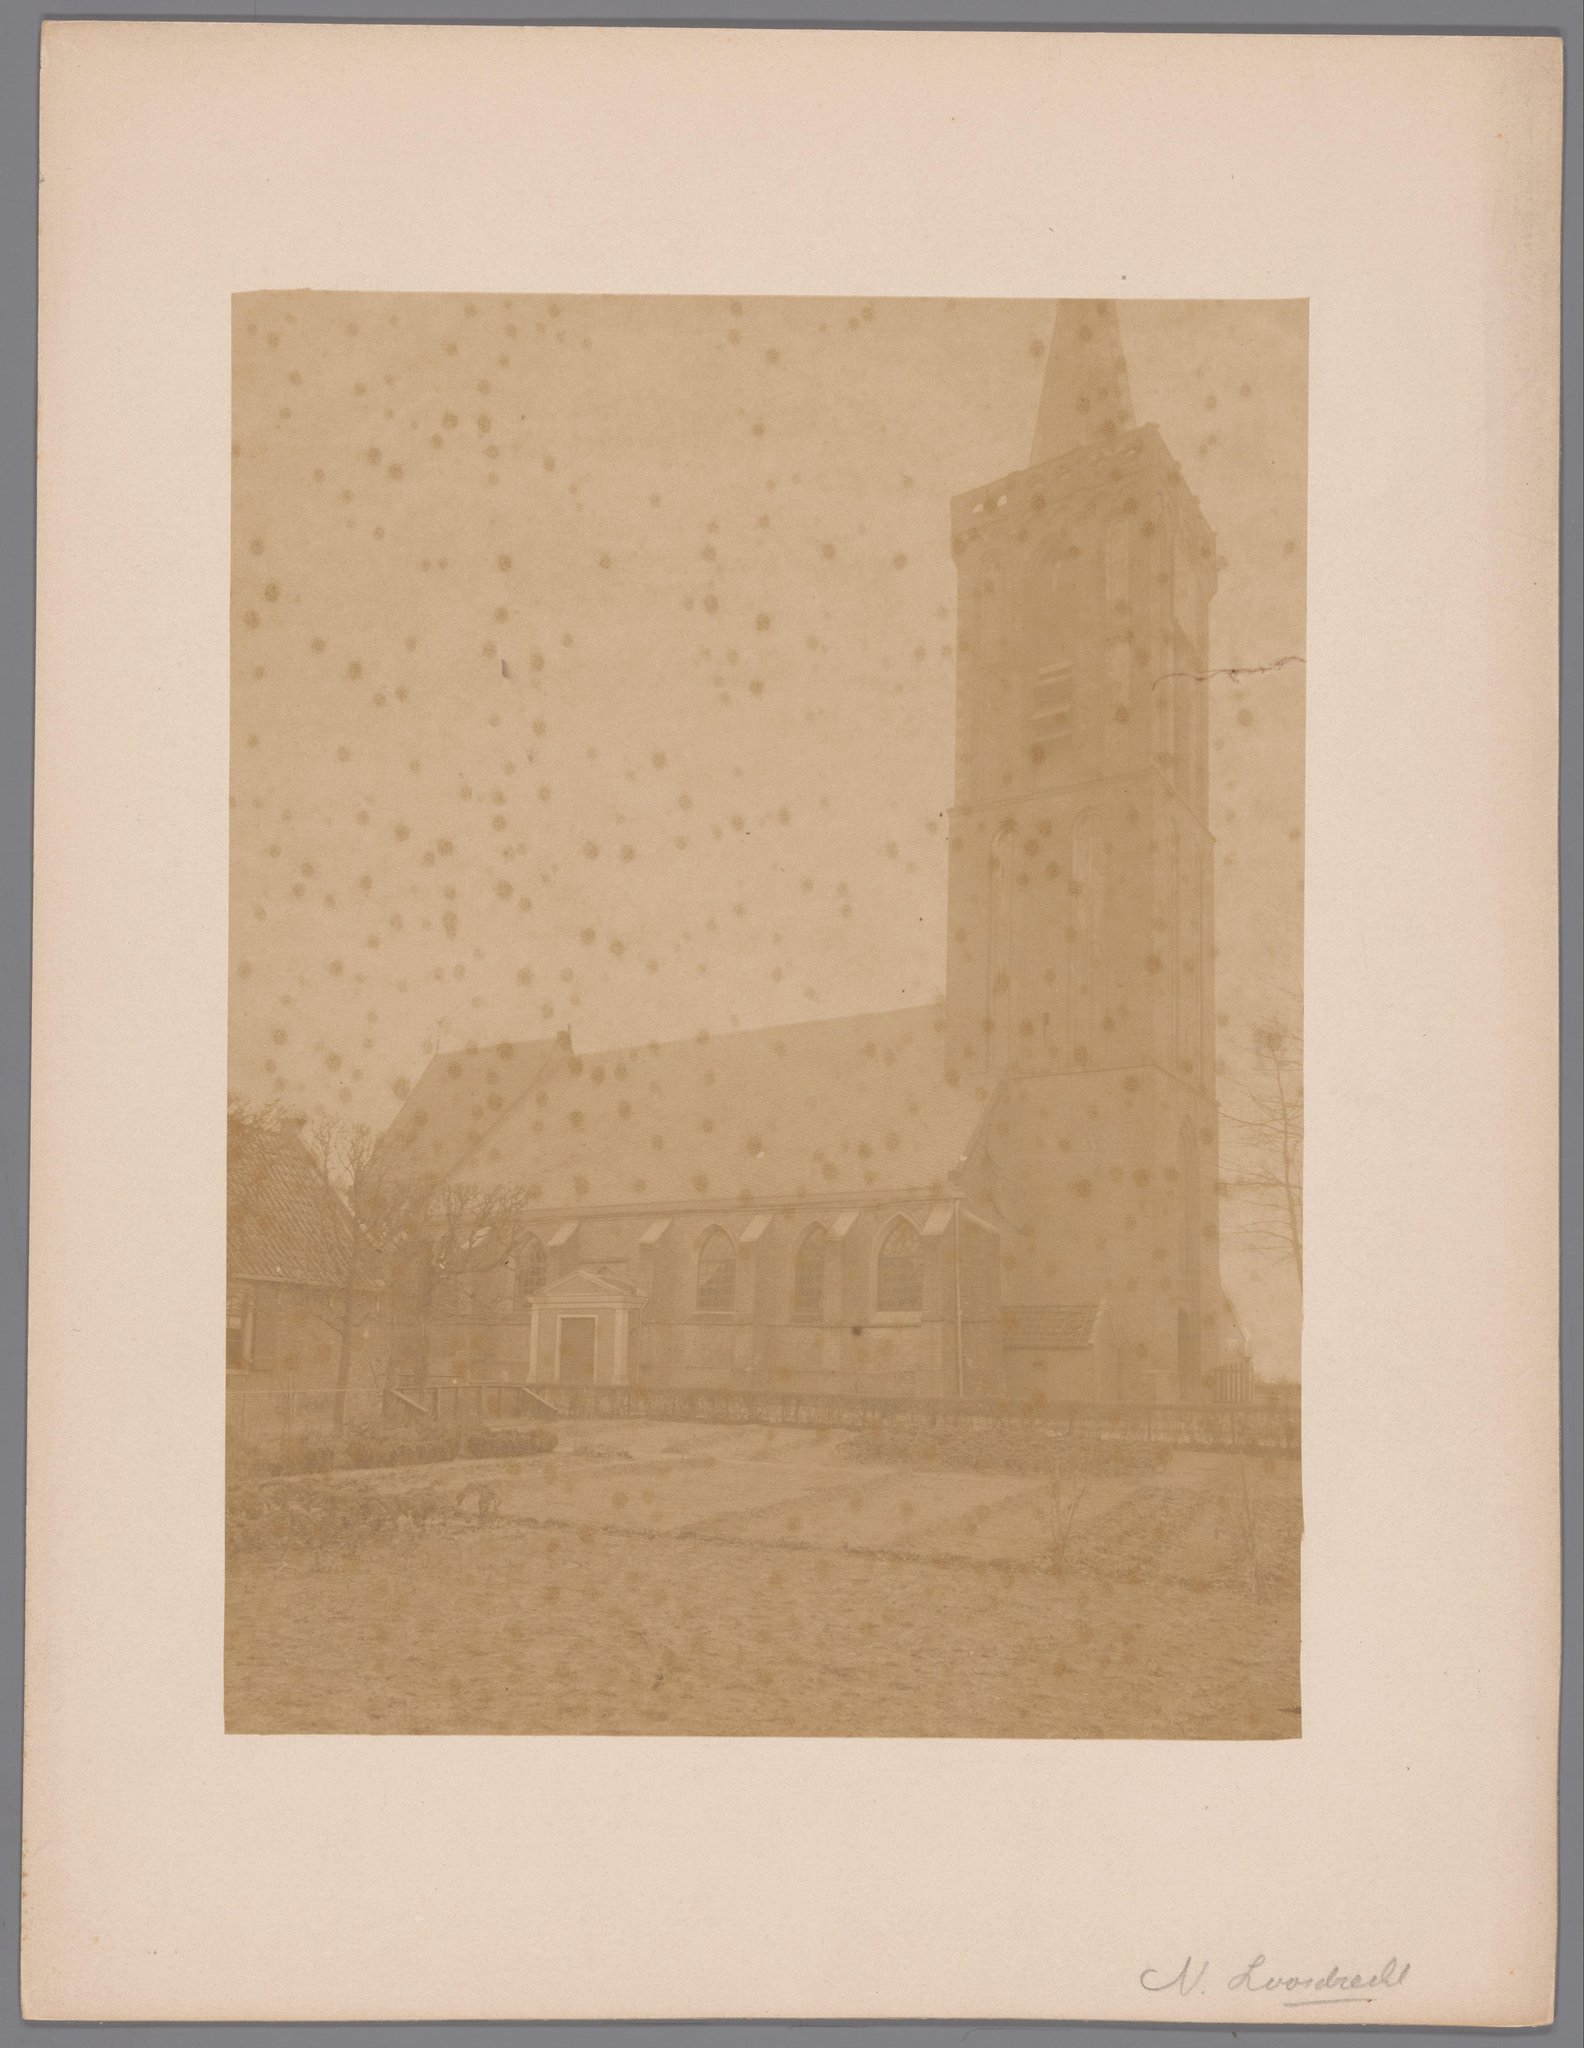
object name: photograph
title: Gezicht op de Sijpekerk te Nieuw-Loosdrecht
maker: anoniem (monumentenzorg)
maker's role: fotograaf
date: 1899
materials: cardboard, photographic support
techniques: albumen print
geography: nieuw-loosdrecht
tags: church (exterior), nieuw-loosdrecht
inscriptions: annotation: ‘N. Loosdrecht’, annotation: ‘N.H. kerk te Nieuw-Loosdrecht (U.)/ jan 1899’